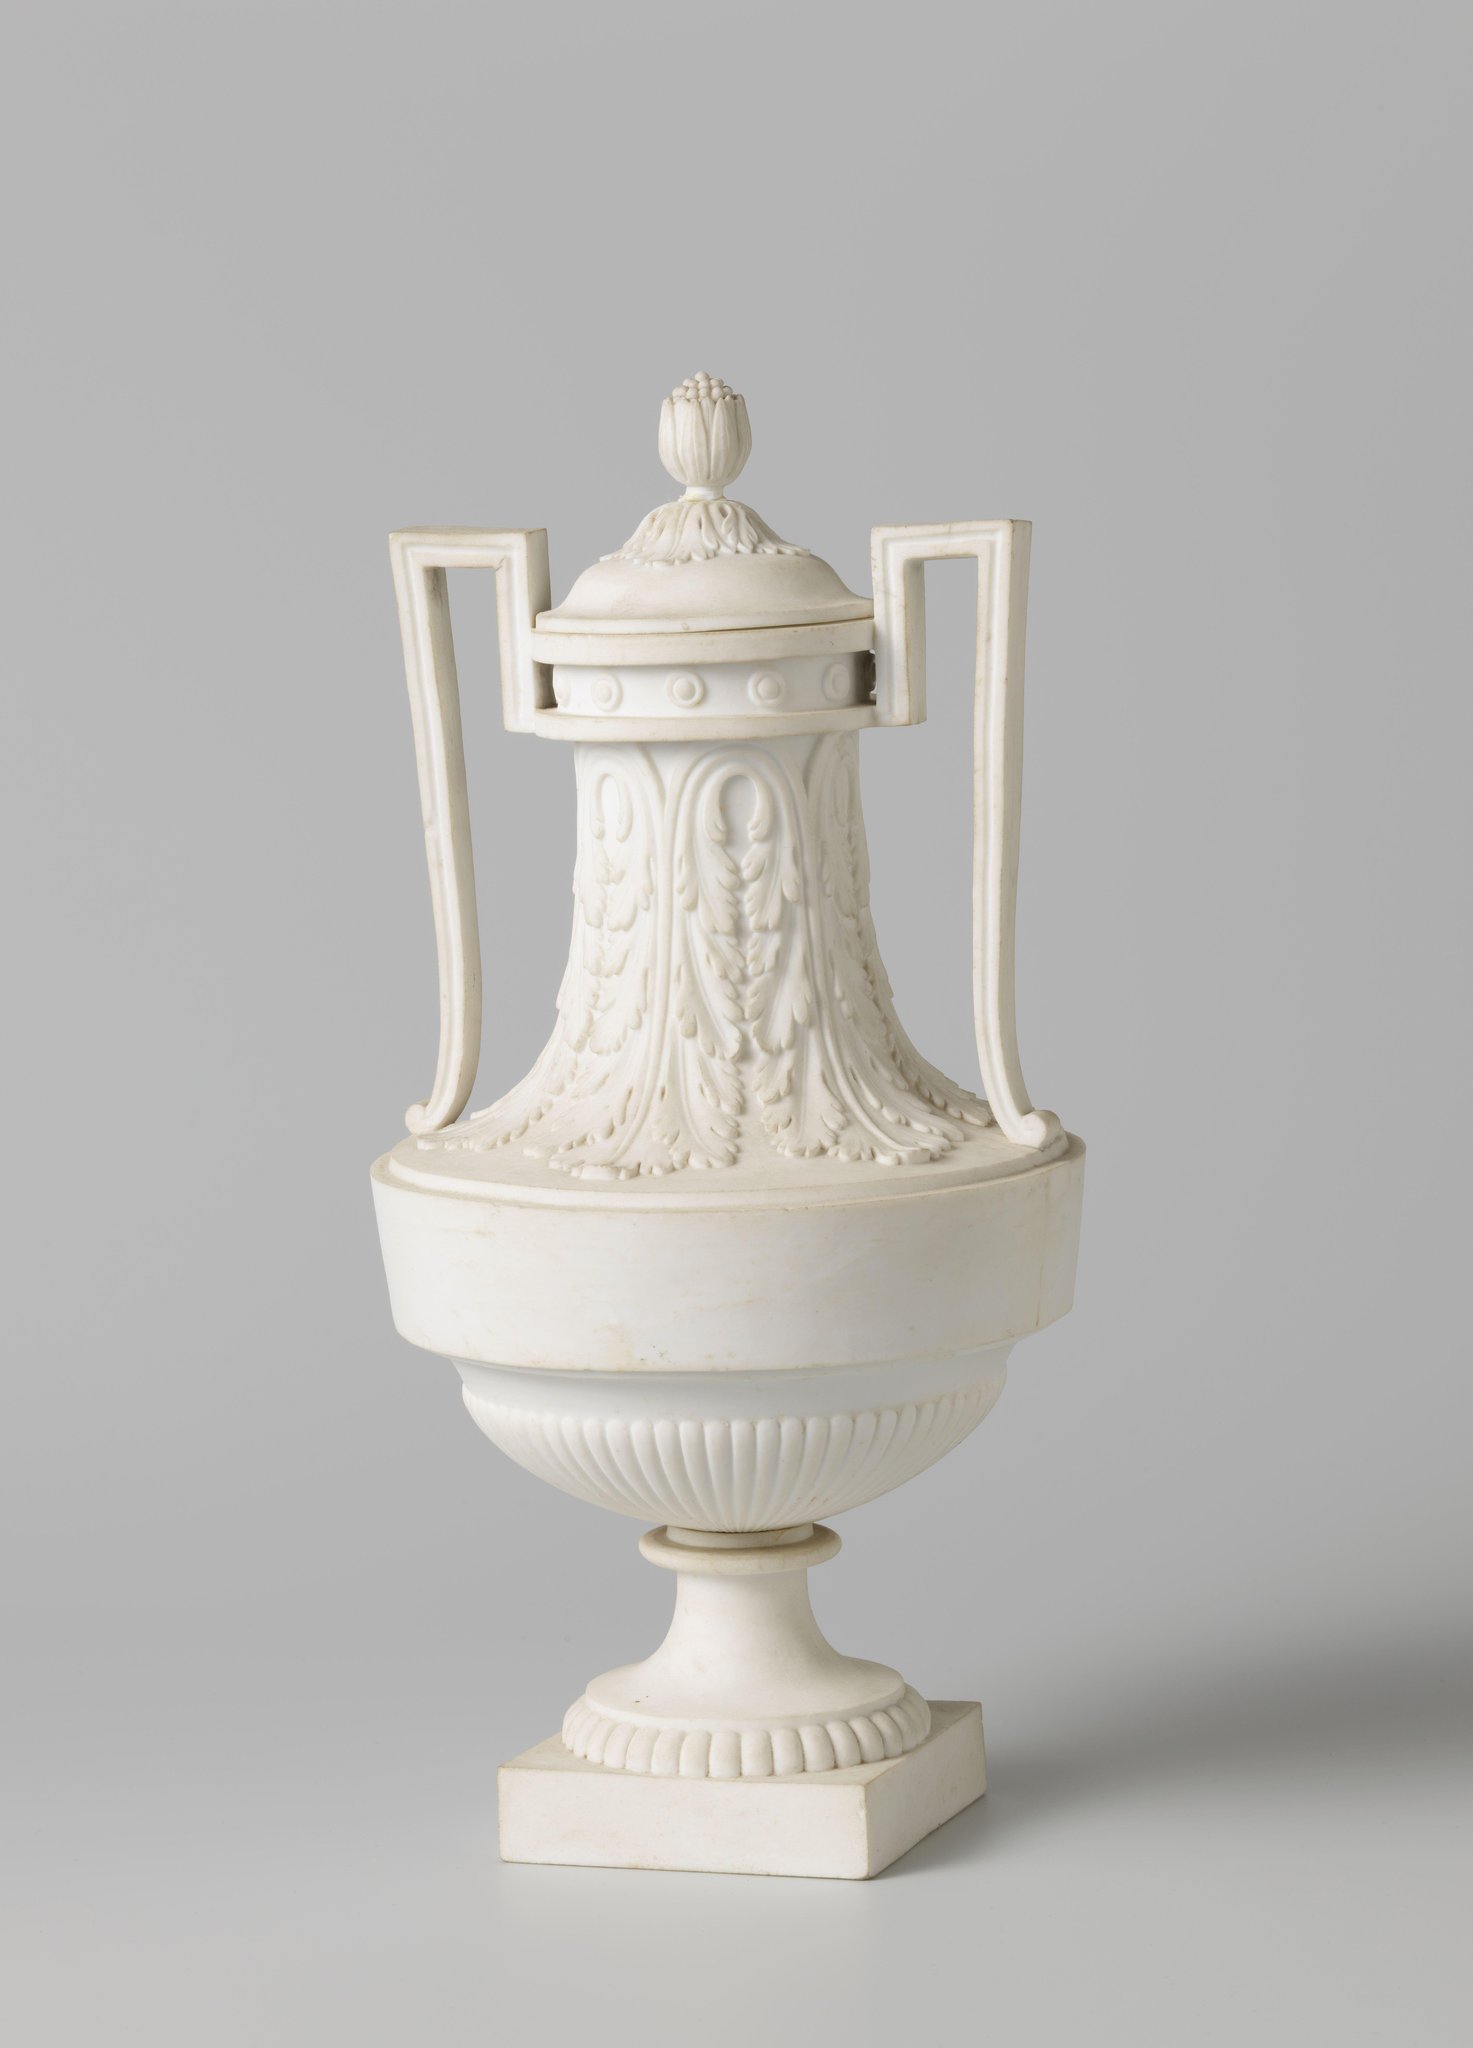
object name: lid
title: Deksel van urn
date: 1780-1790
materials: biscuit porcelain, material)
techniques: biscuit (porcelain, material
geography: paris